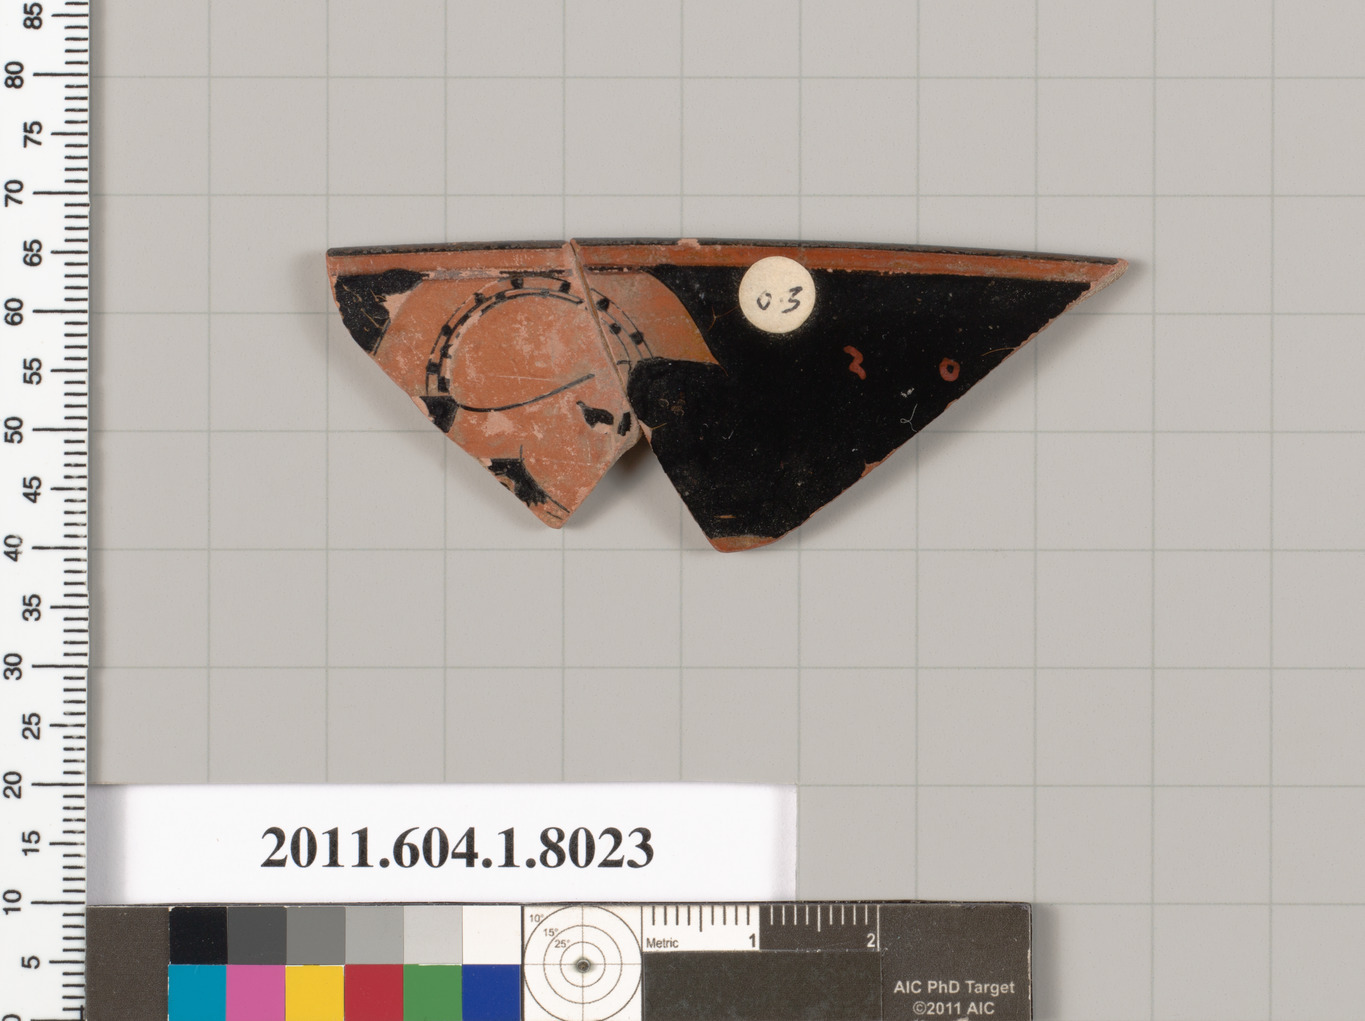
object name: kylix fragment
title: Terracotta rim fragment of a kylix (drinking cup)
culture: greek, attic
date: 510-500 BCE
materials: terracotta